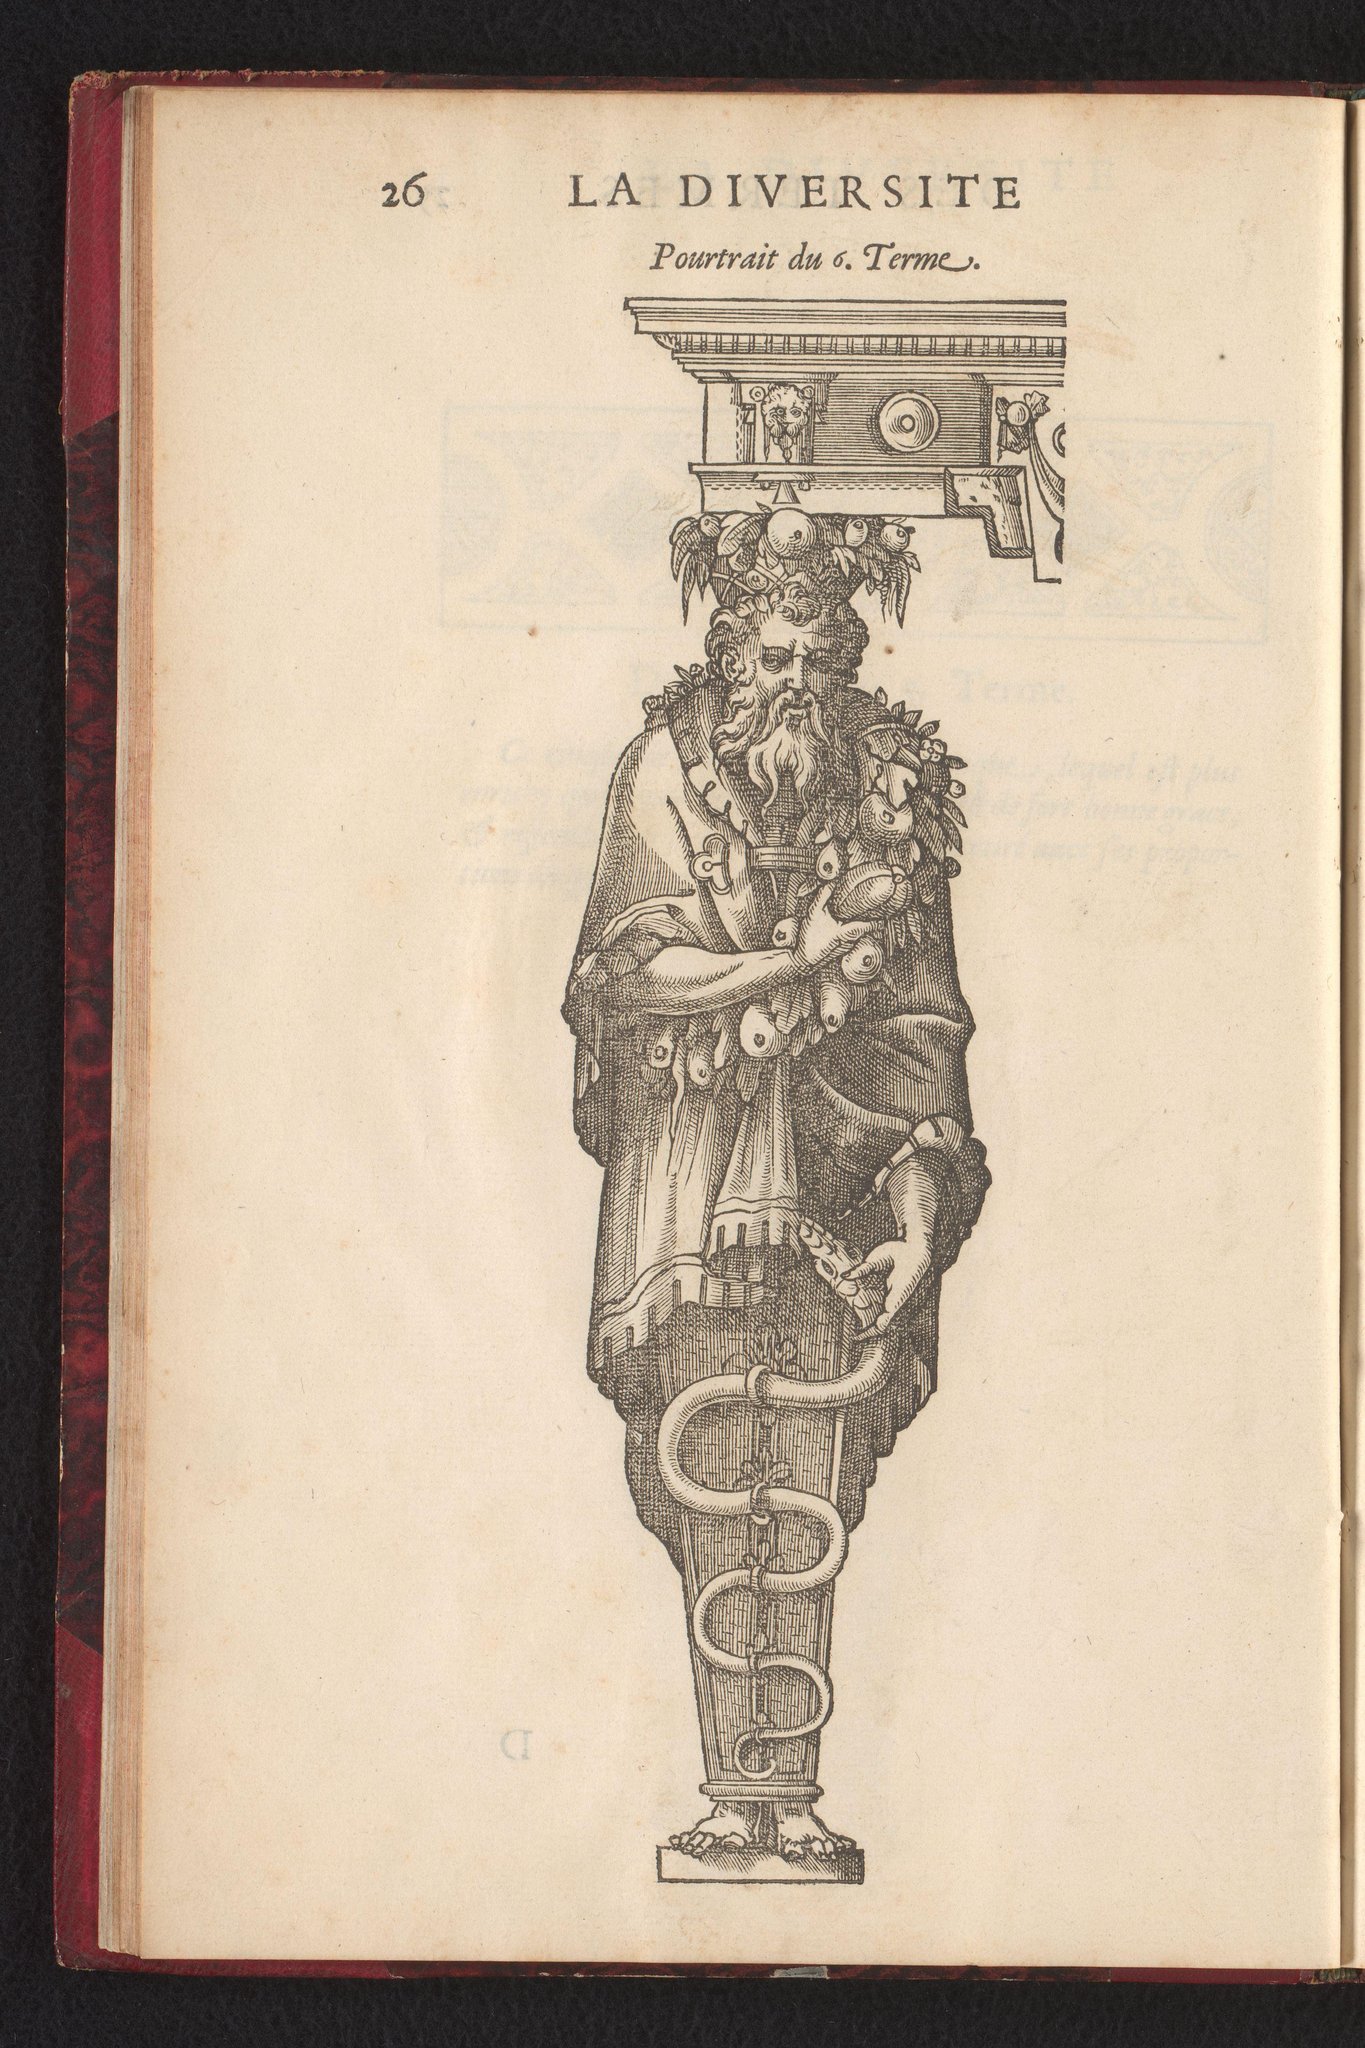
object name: album leaf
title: Mannelijke term met fruit en een slang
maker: Anonymous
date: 1572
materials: paper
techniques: letterpress printing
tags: herms (garden ornaments), pedestal of a piece of sculpture (perhaps in the form of a herm), herm: pillar with the head of mercury, patron of travellers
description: Linksboven genummerd: 26. Volgens de toelichting op pagina 28 gaat het hier om de Dorische orde. Prent maakt deel uit van een album.